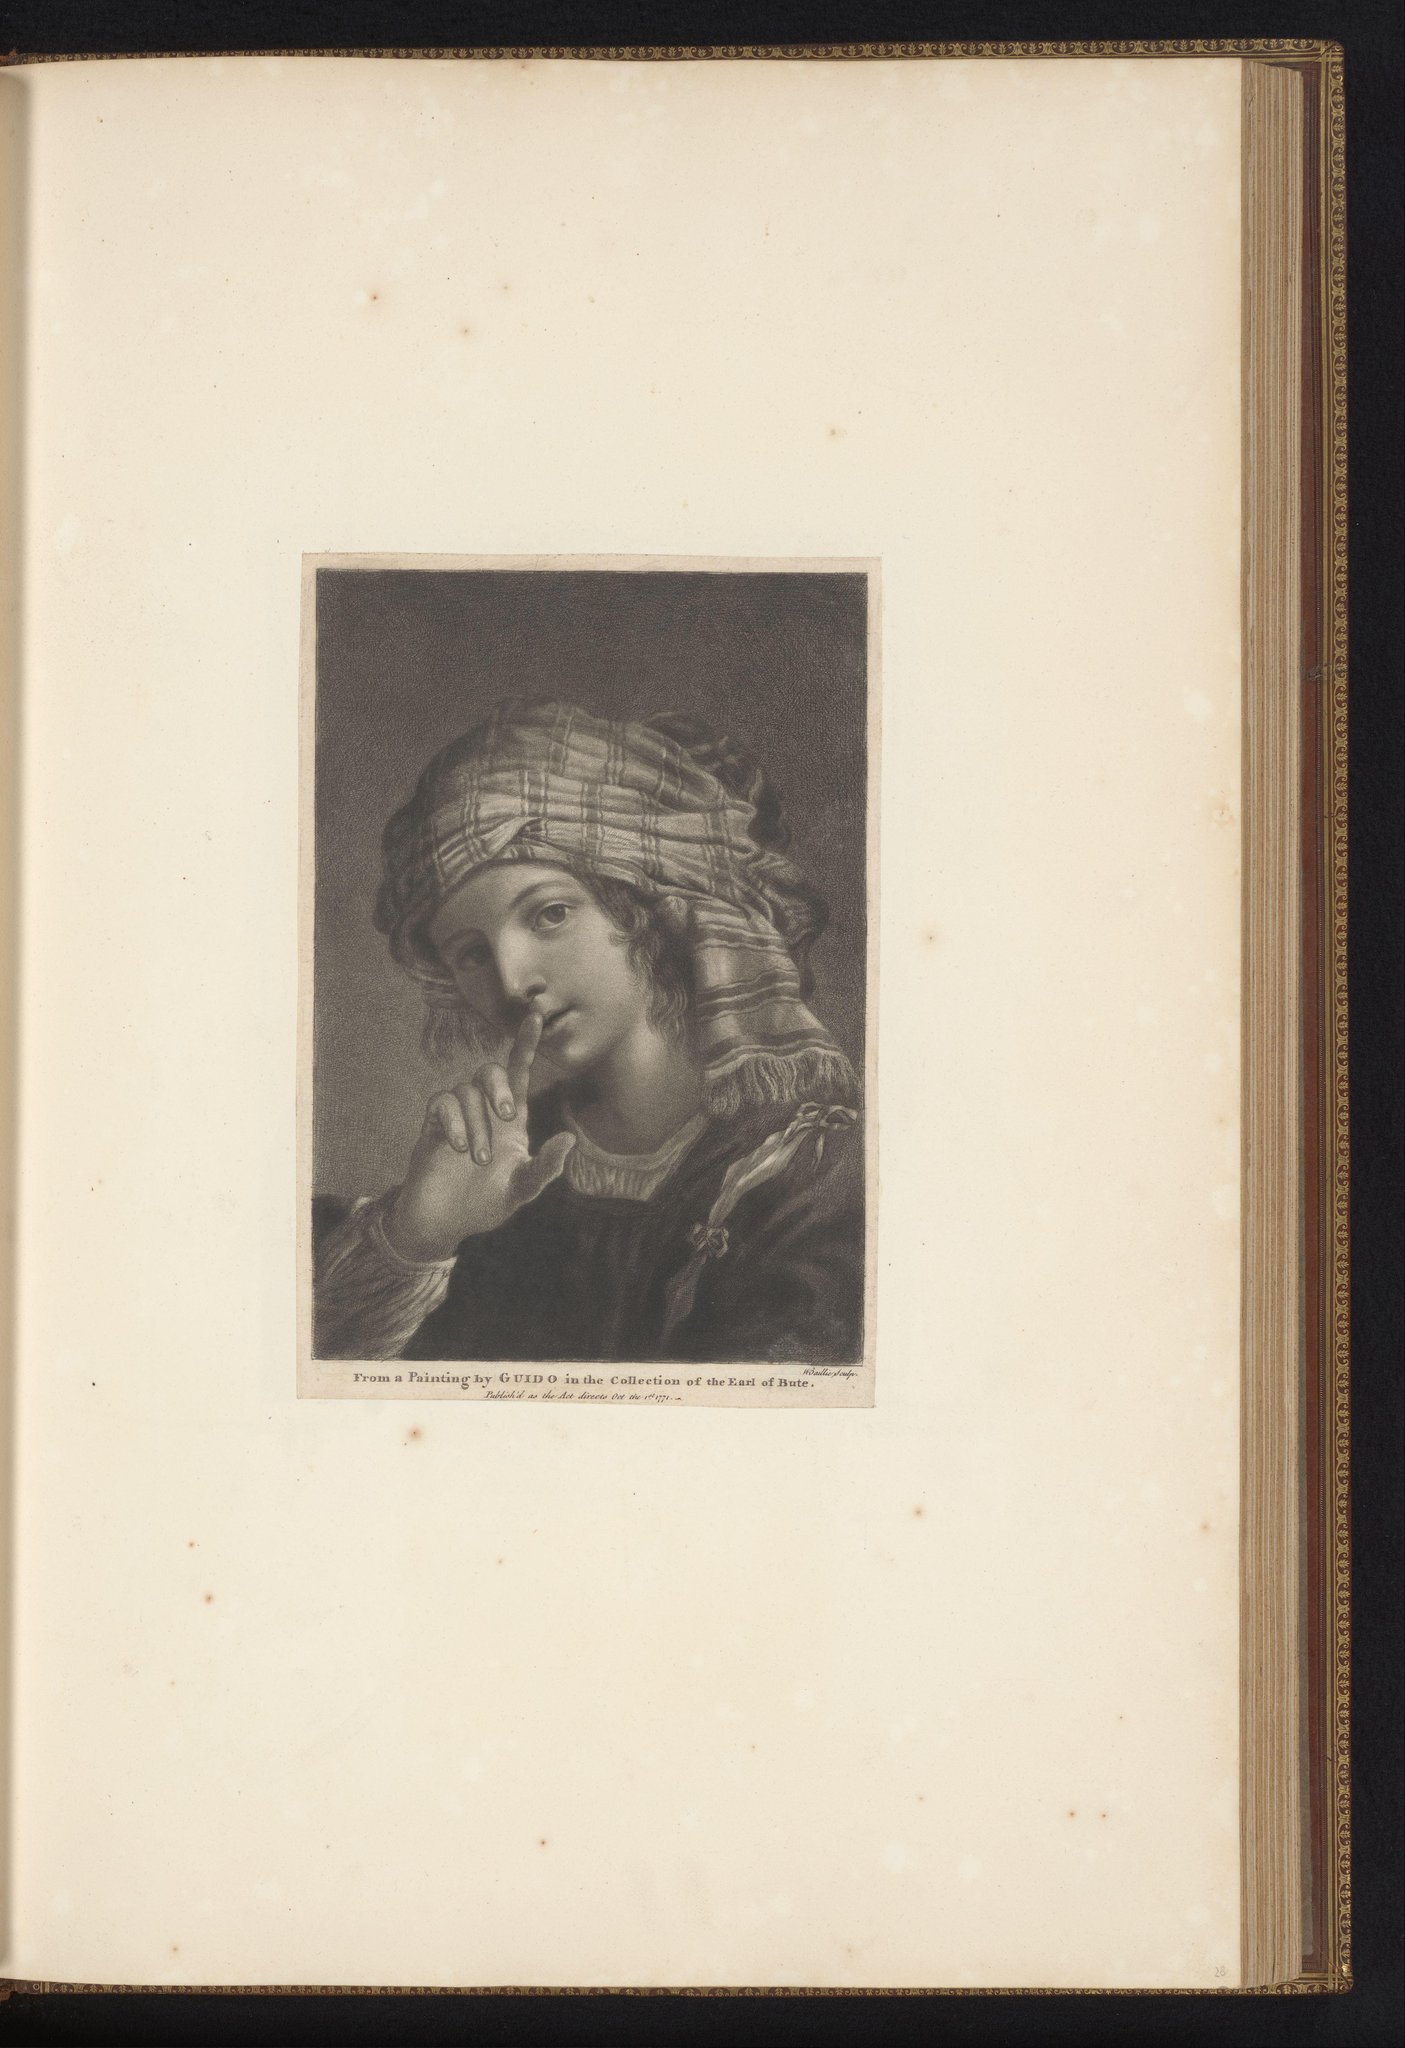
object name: album leaf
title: Jonge vrouw maakt stiltegebaar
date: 1771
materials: paper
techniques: etching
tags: putting a finger to the lips, 'silentium'; 'silentio' (ripa)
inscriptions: date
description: Een jonge vrouw maakt met een vinger bij haar mond een stiltegebaar. Ze draagt een doek om haar hoofd. De prent maakt deel uit van een album.